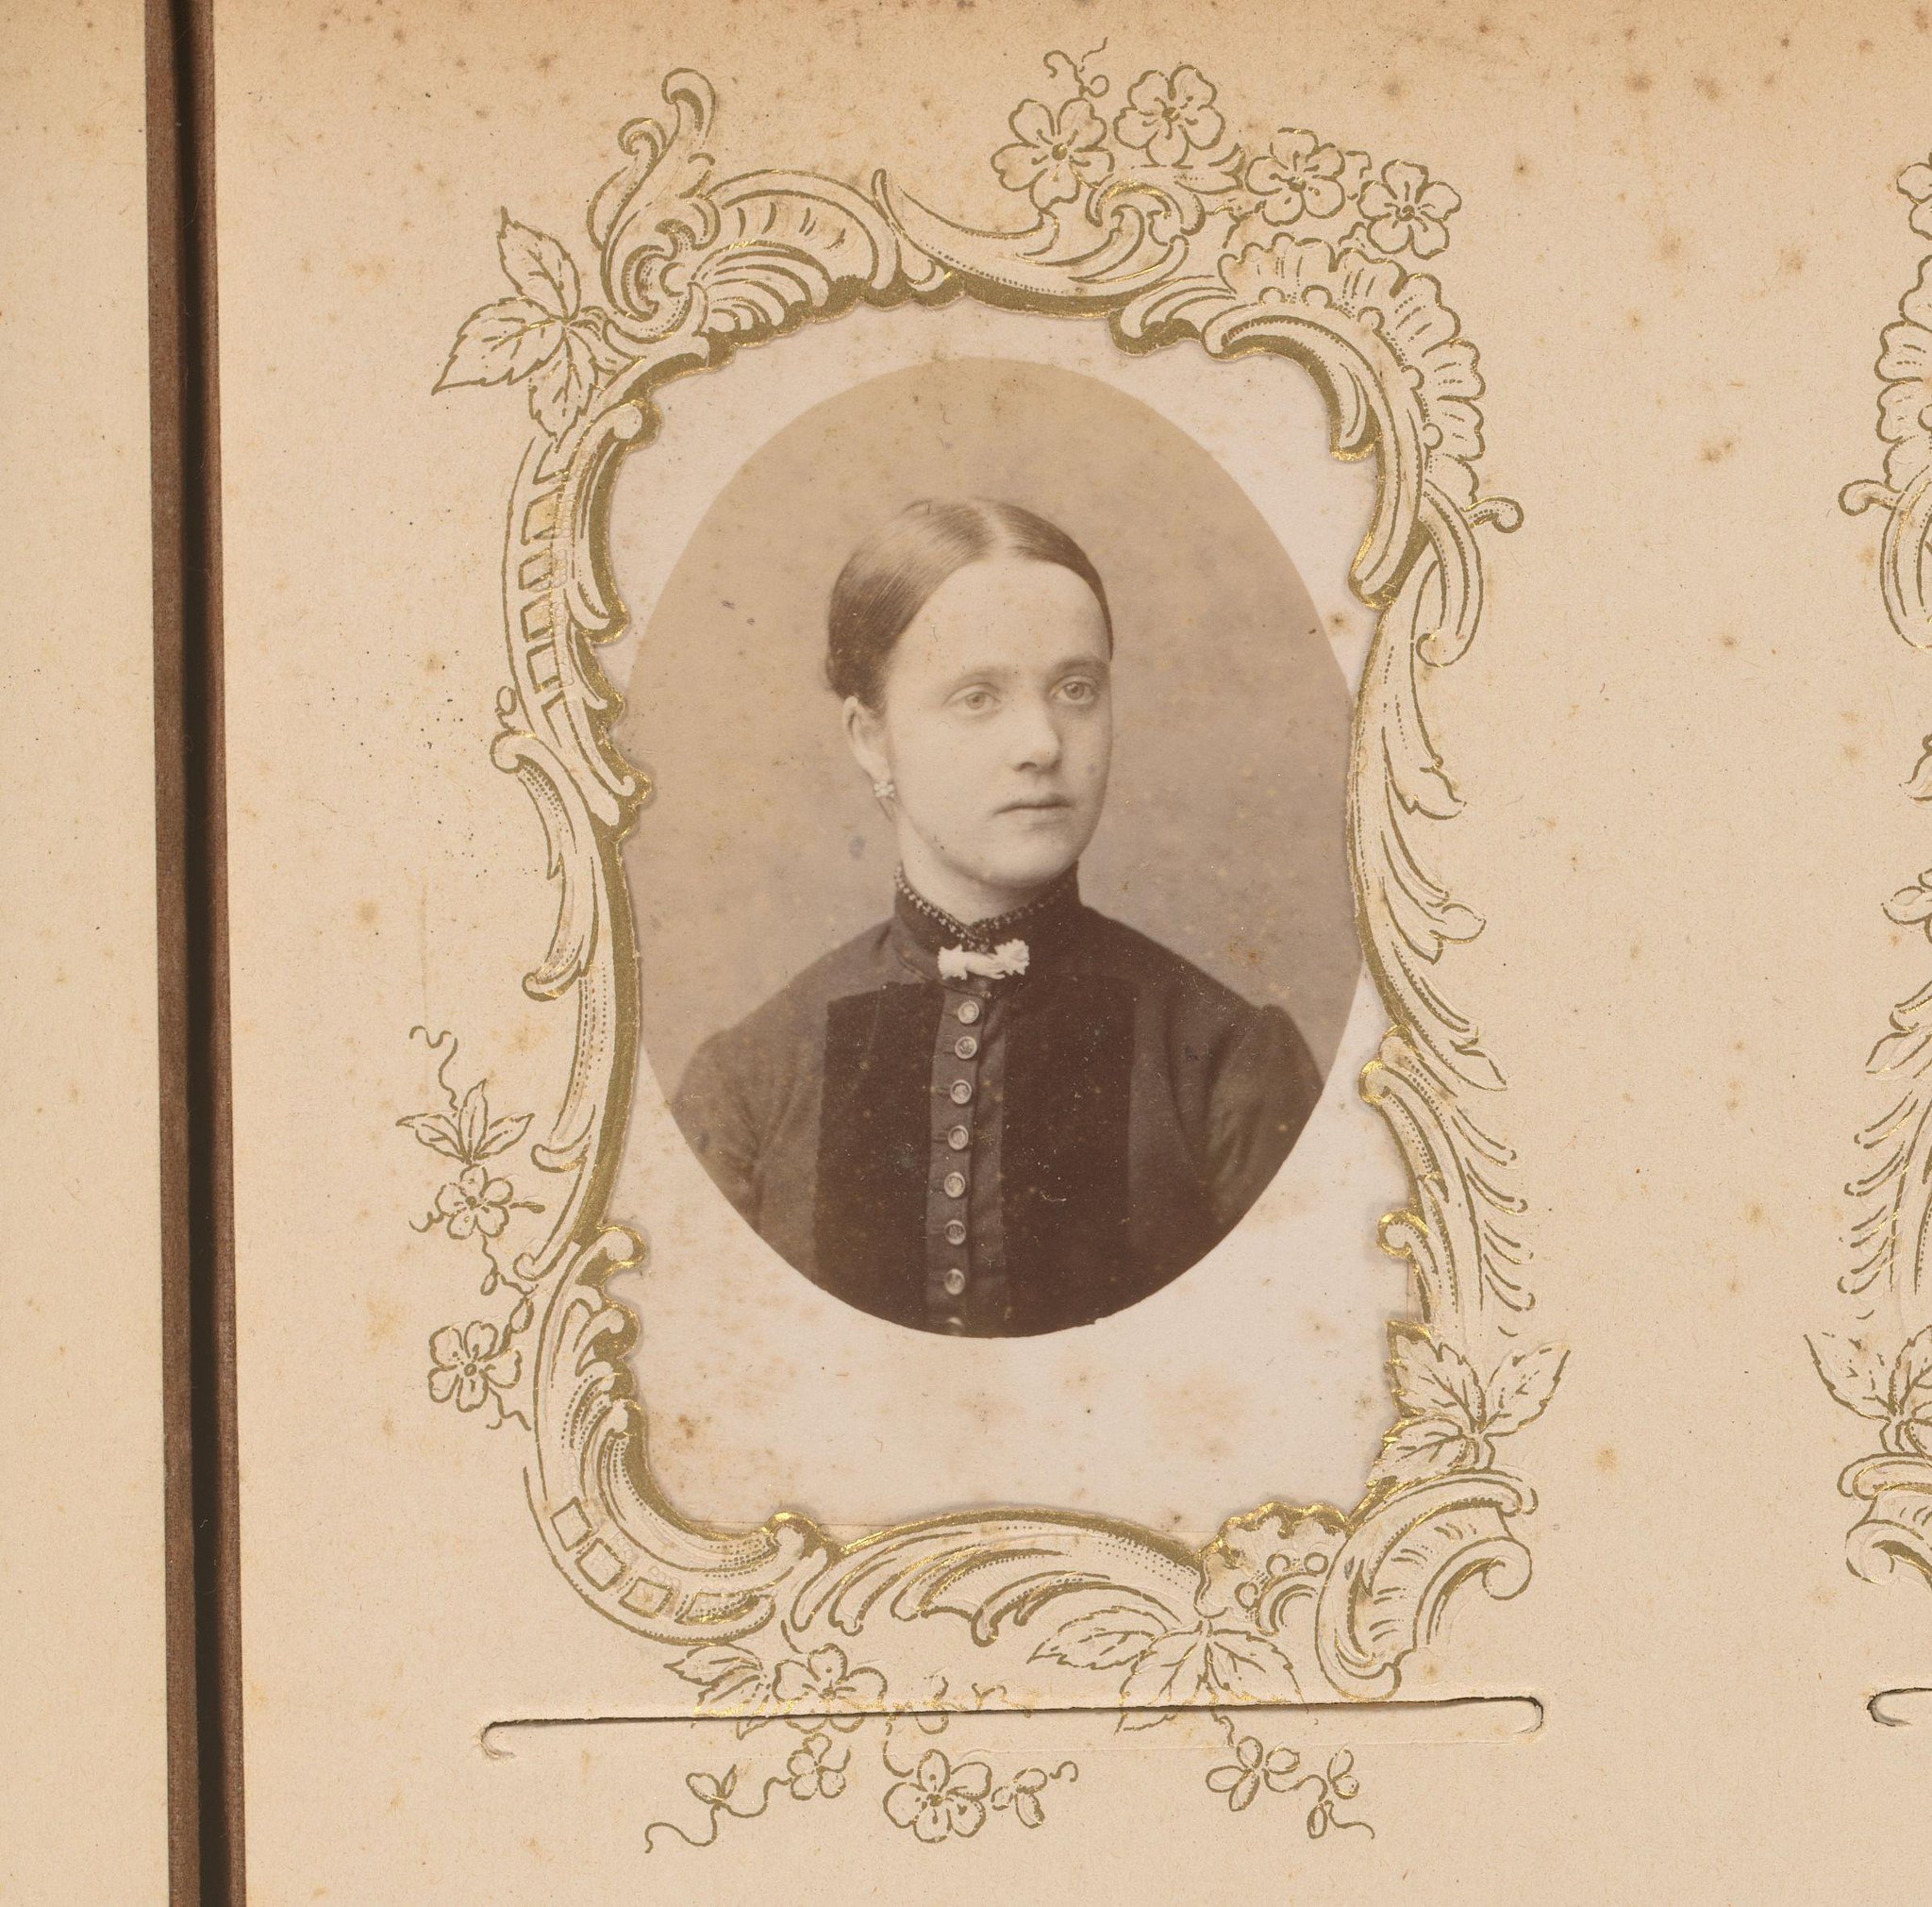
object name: album leaf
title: Portret van een jonge vrouw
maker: Anonymous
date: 1860-1890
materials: cardboard, photographic support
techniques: albumen print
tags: adolescent, young woman, maiden, historical persons - bb - woman